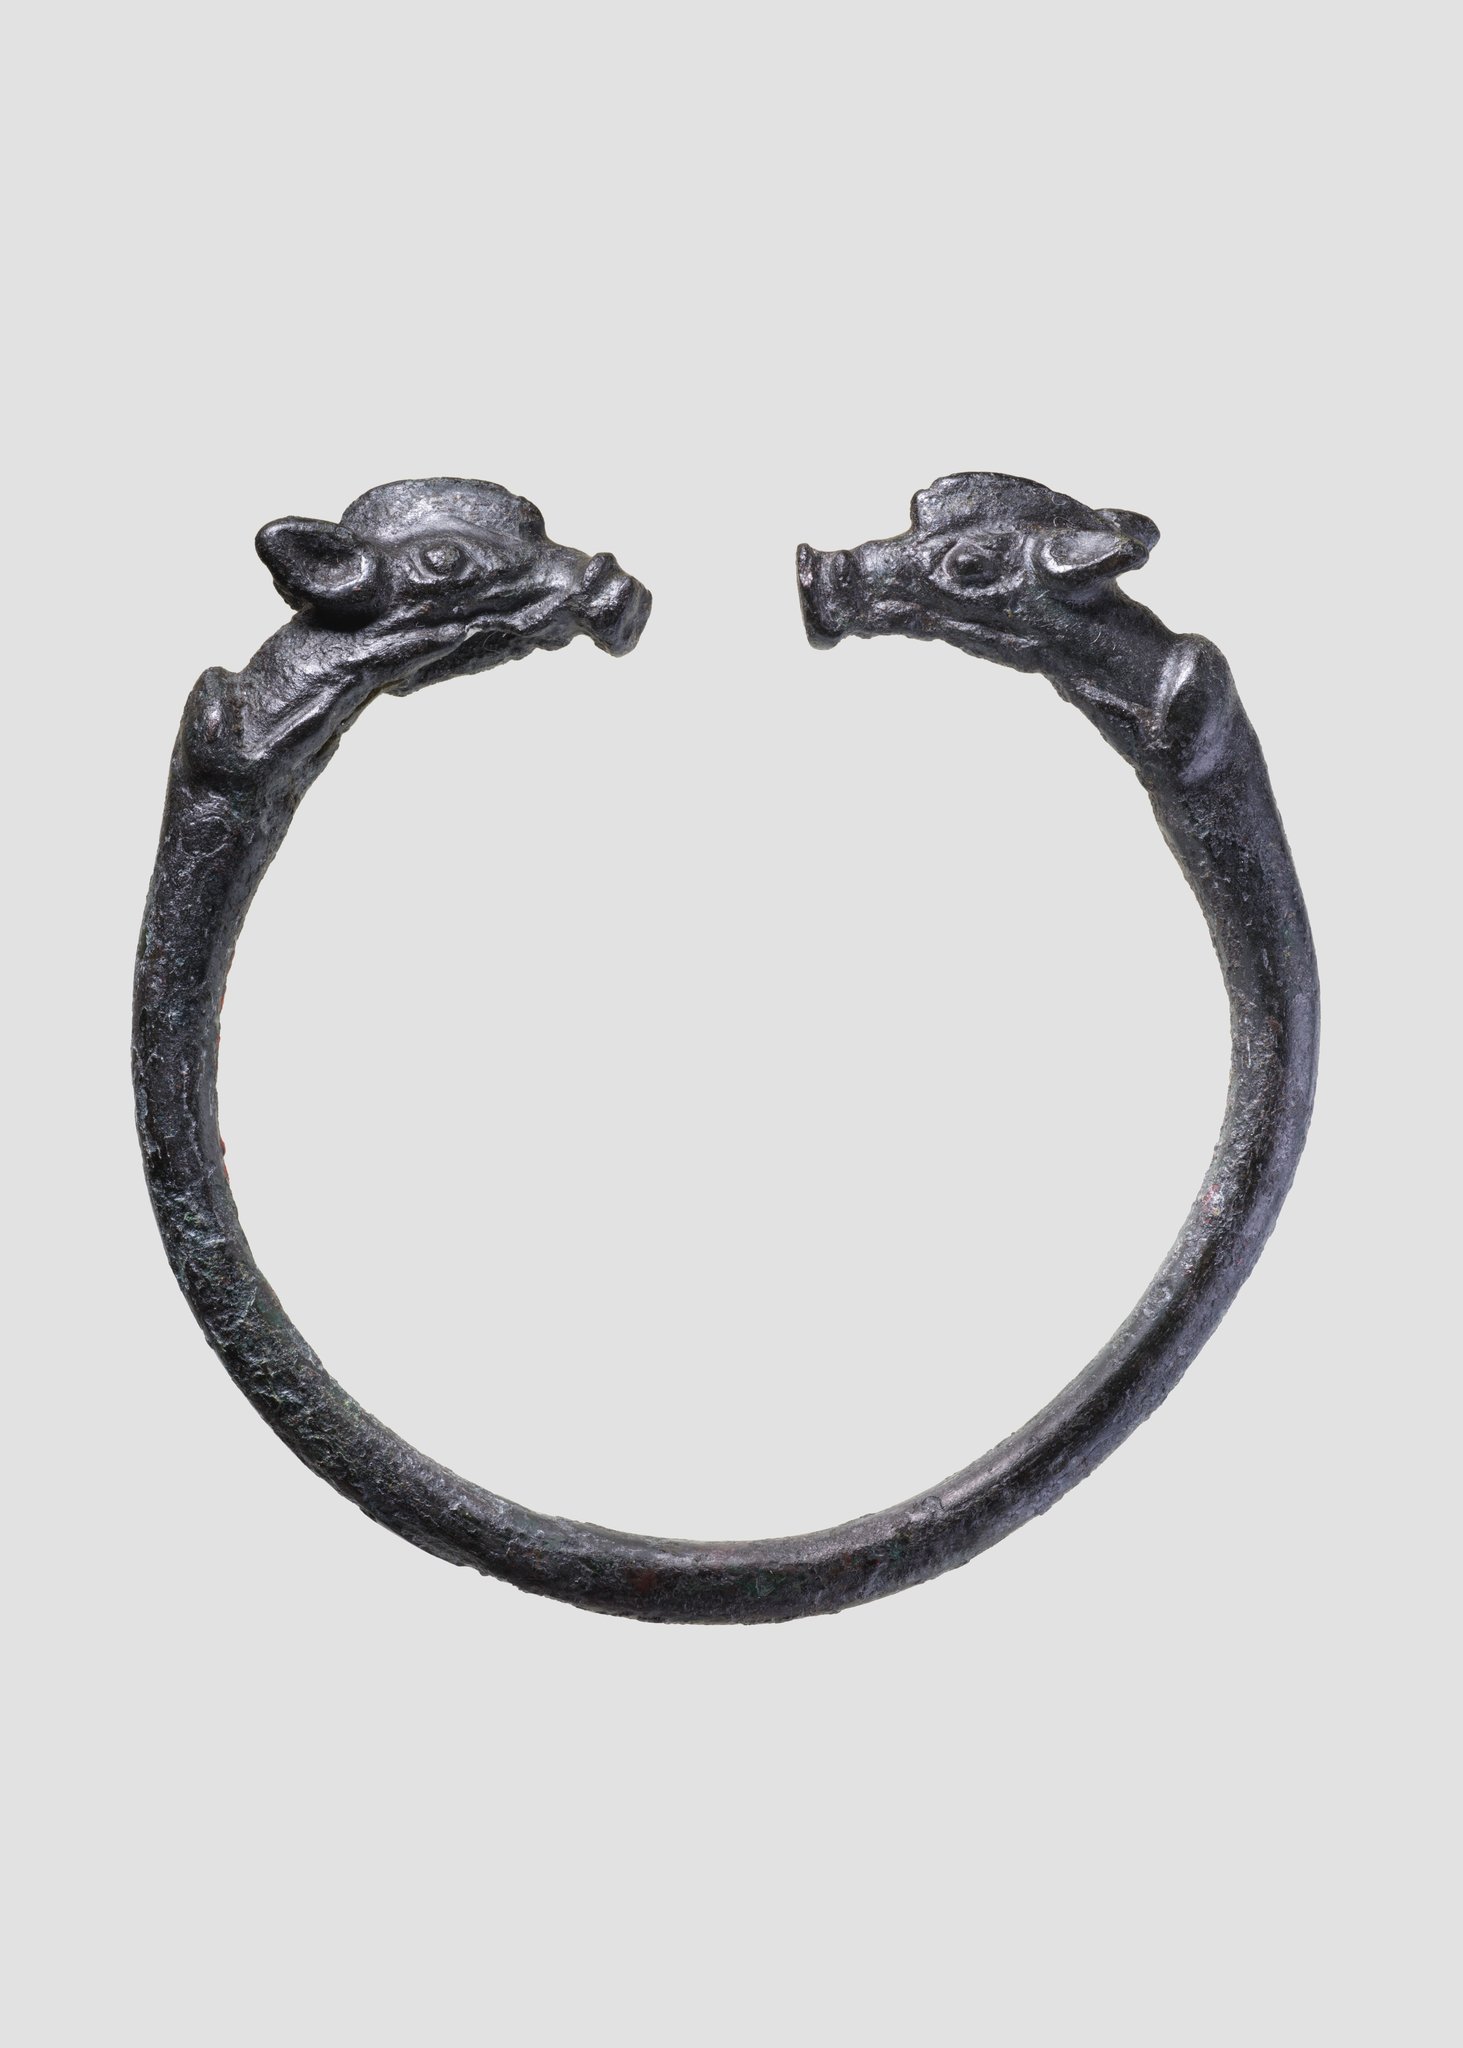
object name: bracelet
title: Bracelet with boar terminals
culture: iranian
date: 800-601 BCE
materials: bronze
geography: iran, probably from luristan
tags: boars